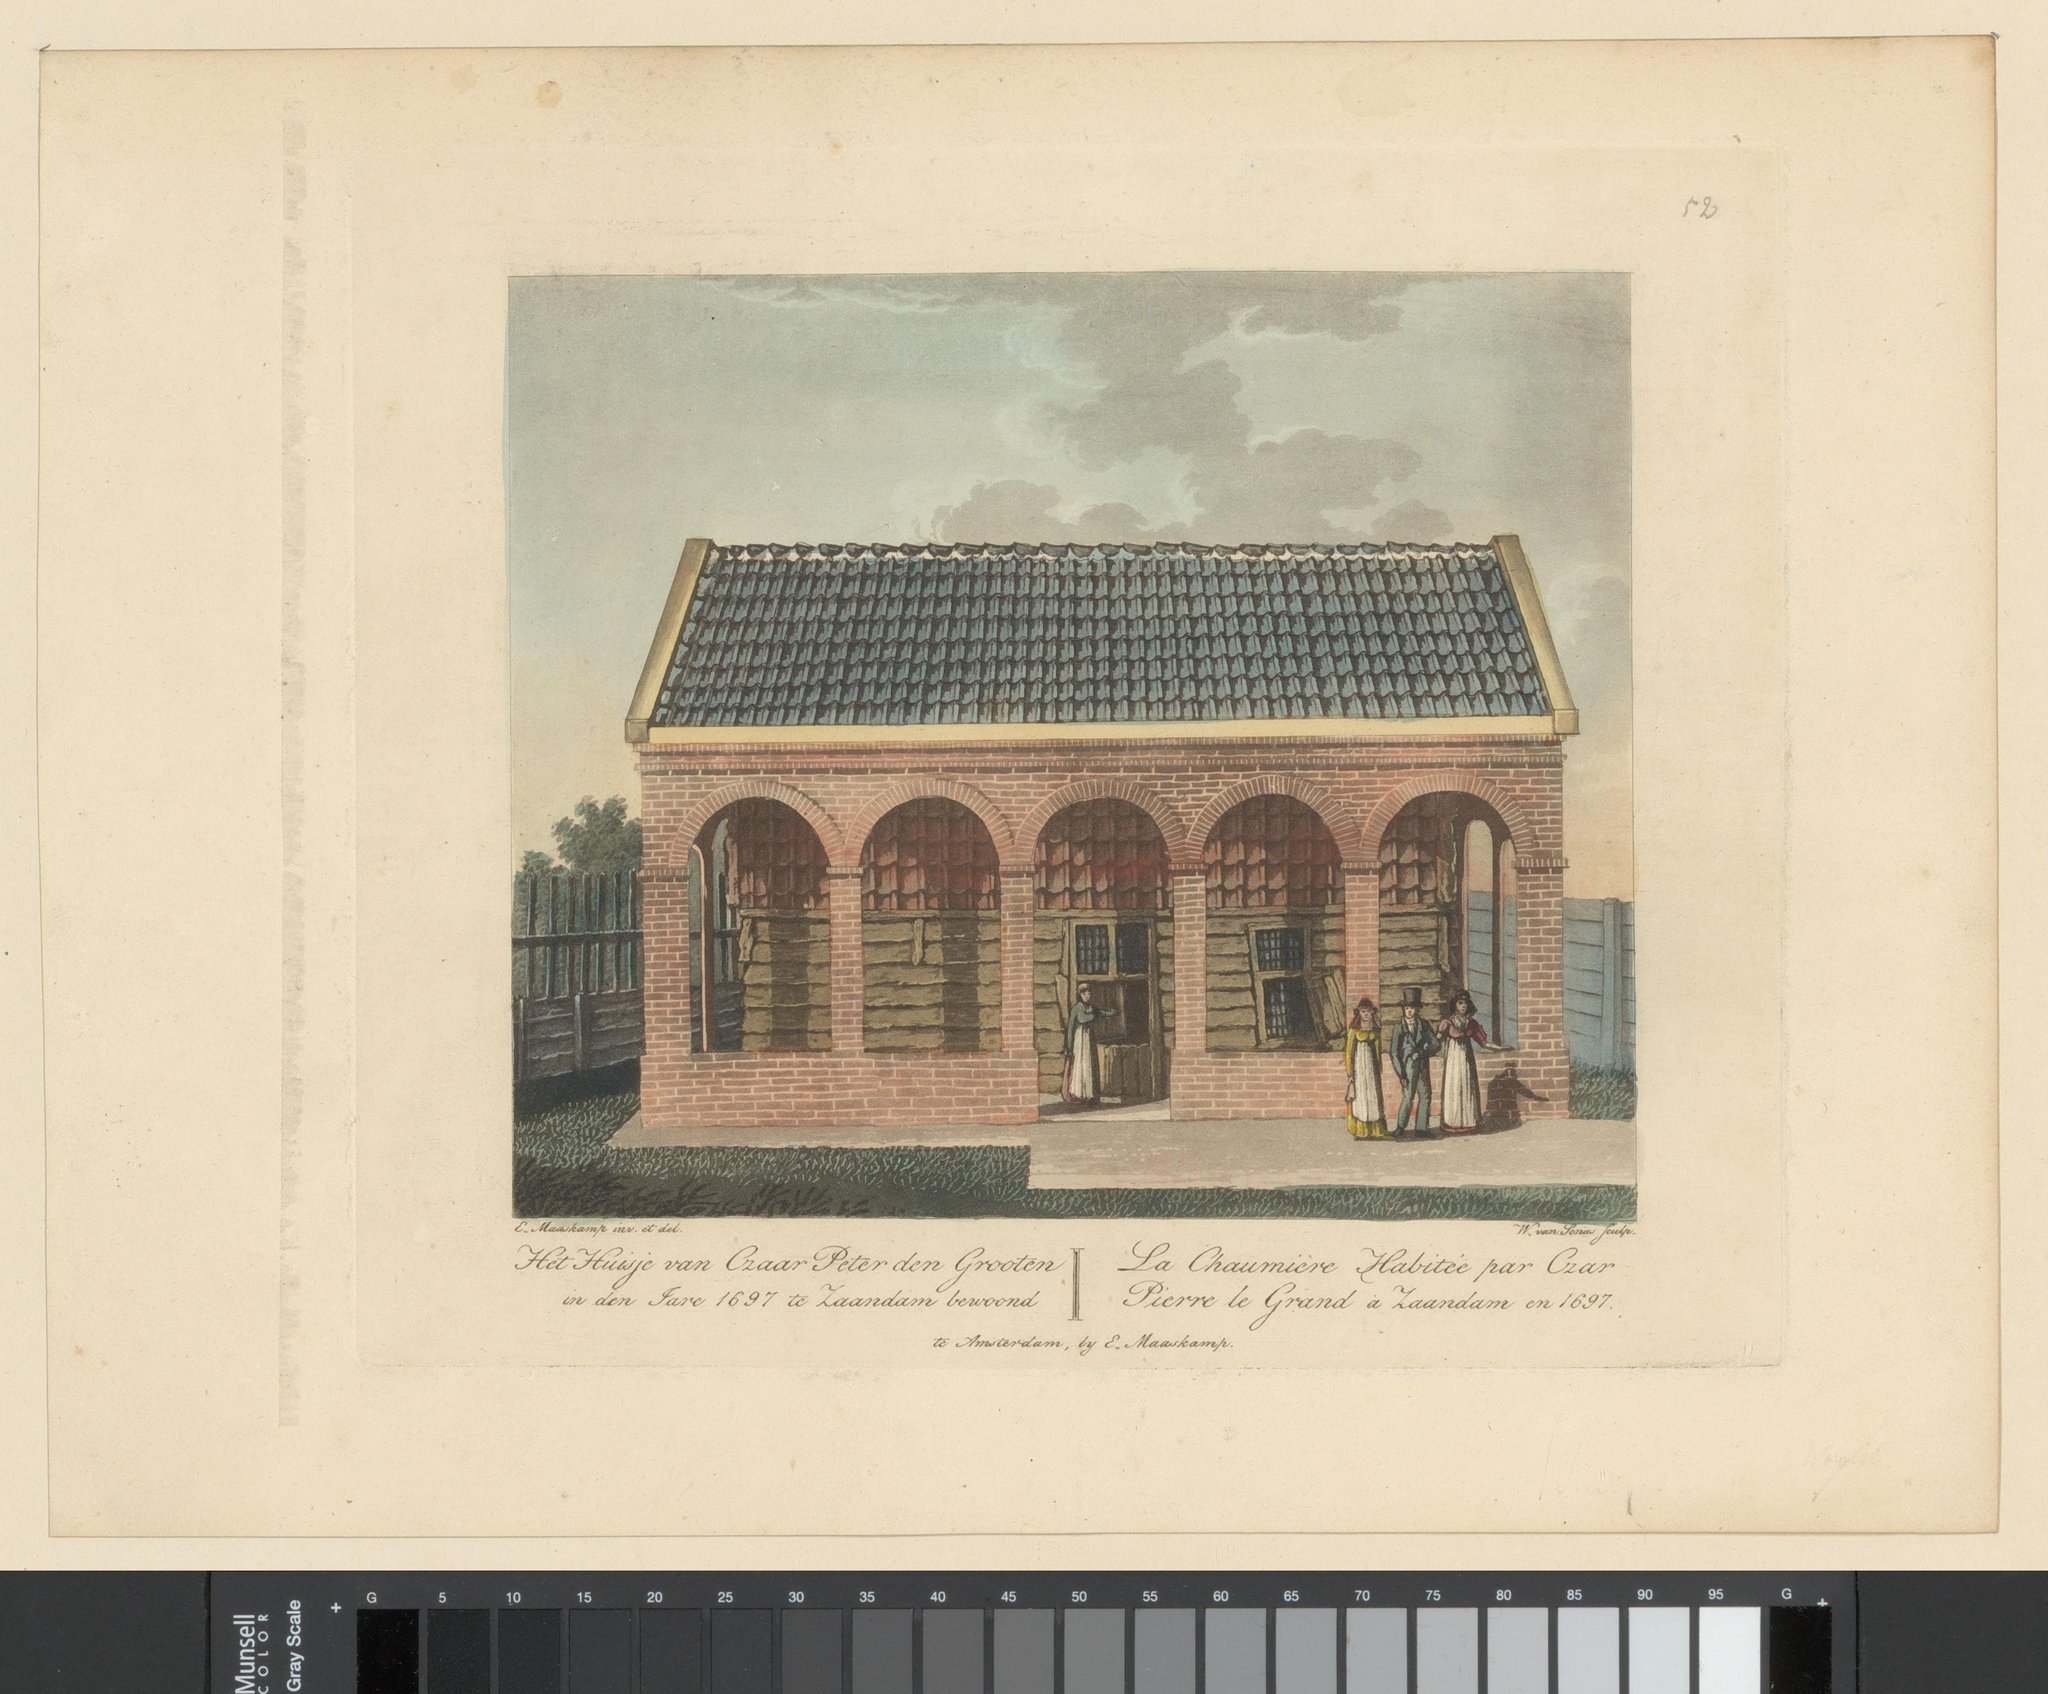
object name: print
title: Tsaar Peterhuisje te Zaandam, 1820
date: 1824-1825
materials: paper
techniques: aquatint, engraving, etching, hand coloring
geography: amsterdam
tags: emperor, cottage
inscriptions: stamp, collector's mark: Lugt 1641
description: Het Tsaar Peterhuisje te Zaandam, waar tsaar Peter de Grote verbleef in augustus 1697. Met het stenen omhulsel uit 1820 en enkele bezoekers. Onderwerpsrubrieken binnen de Atlas Zeden en Gewoonten: Handel, Nijverheid en Verkeer, Scheepsbouw.